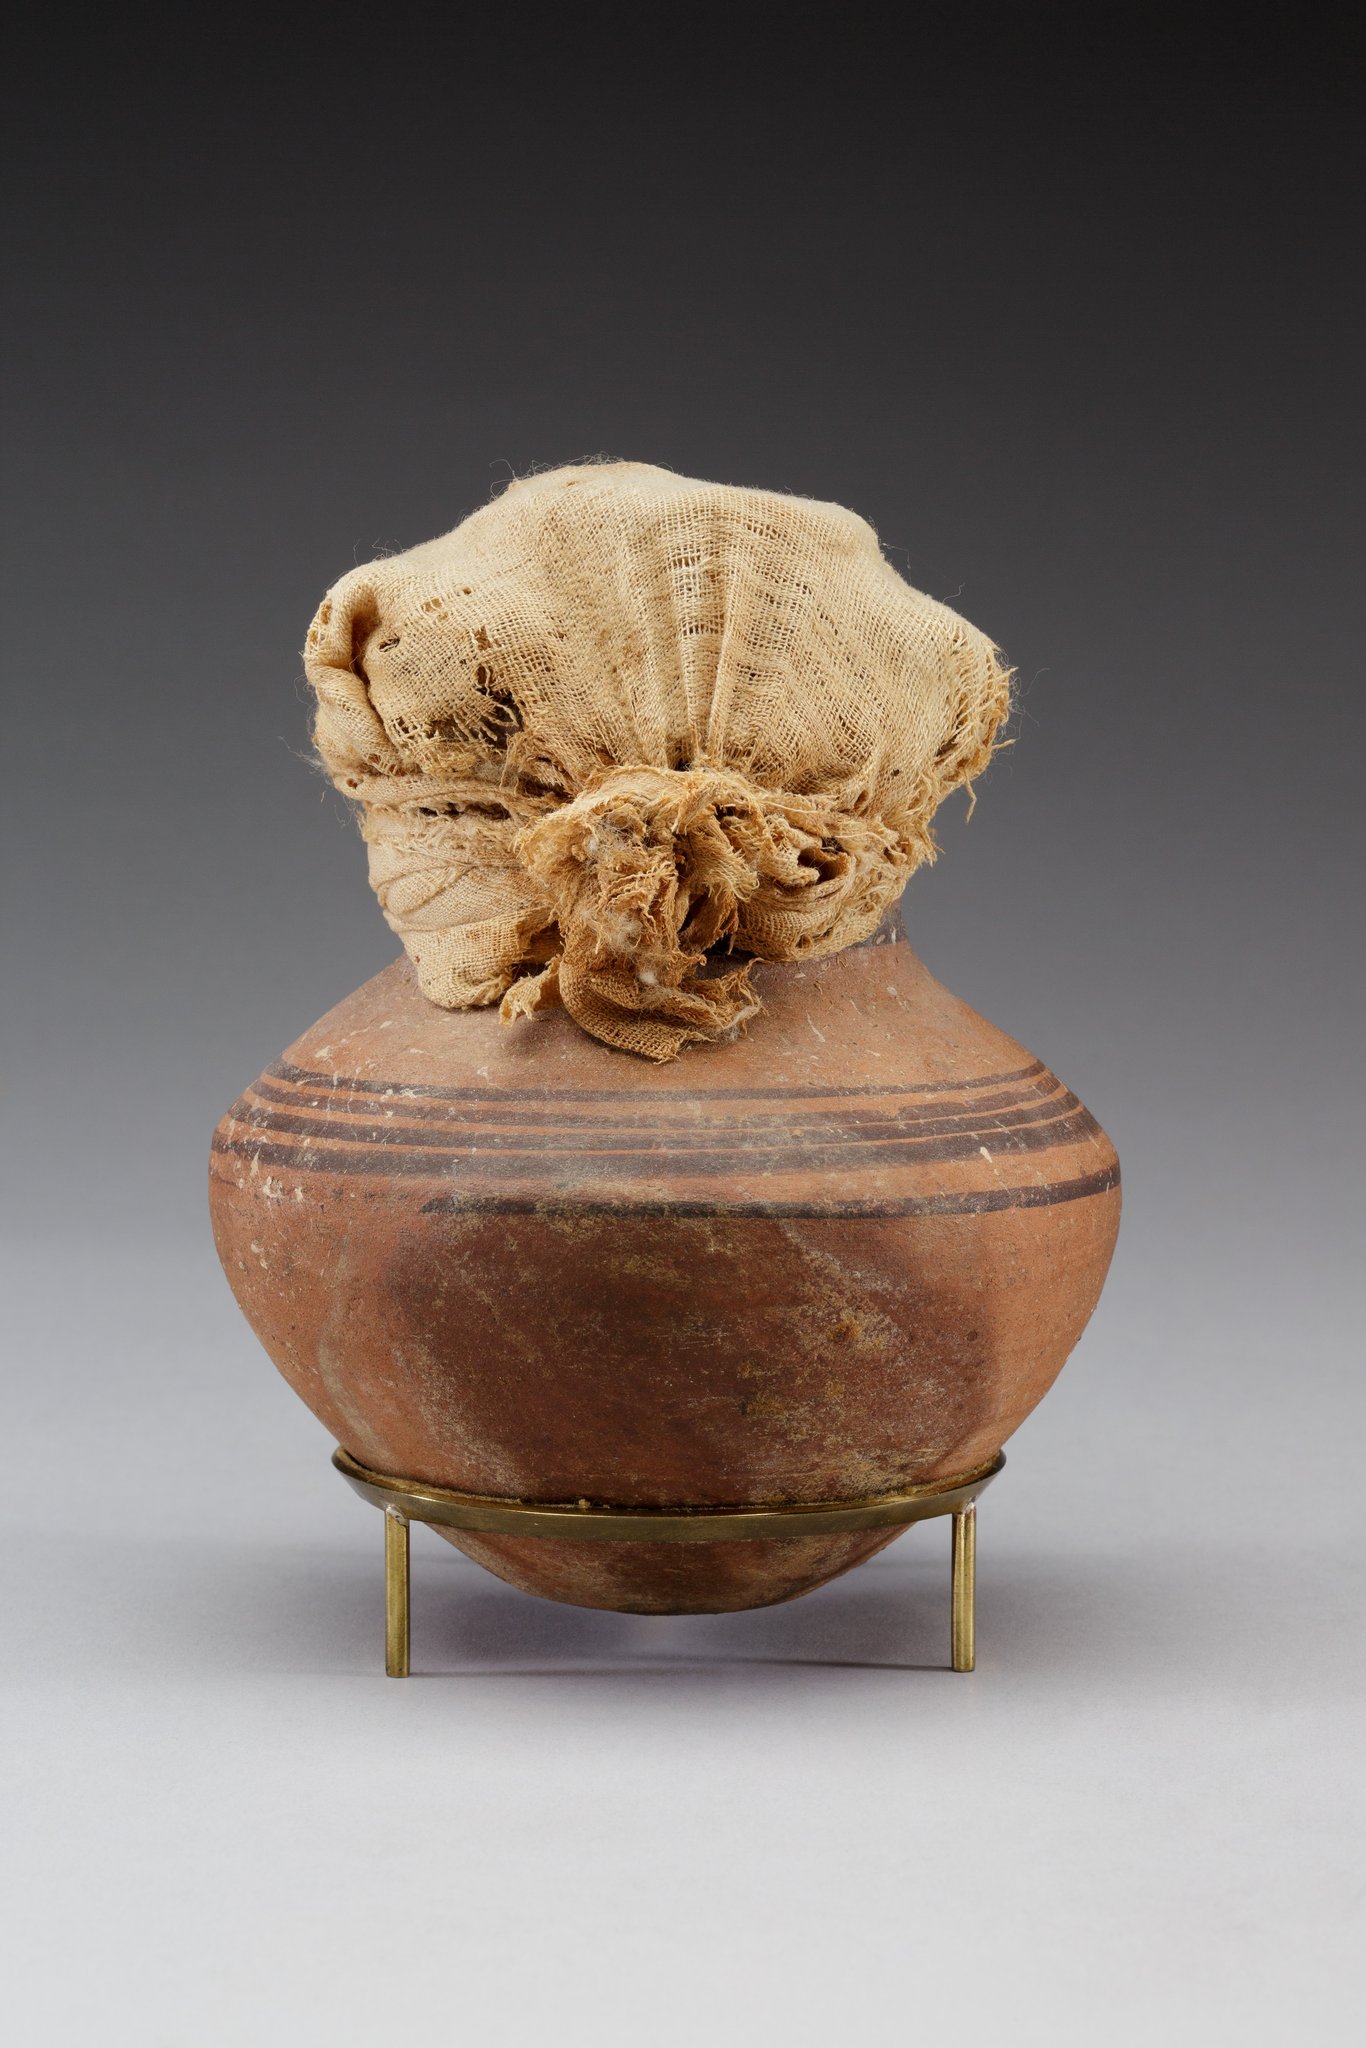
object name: jar, saucer, sealed, linen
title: Sealed Jar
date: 1479-1458 BCE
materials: linen, paint, pottery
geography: egypt